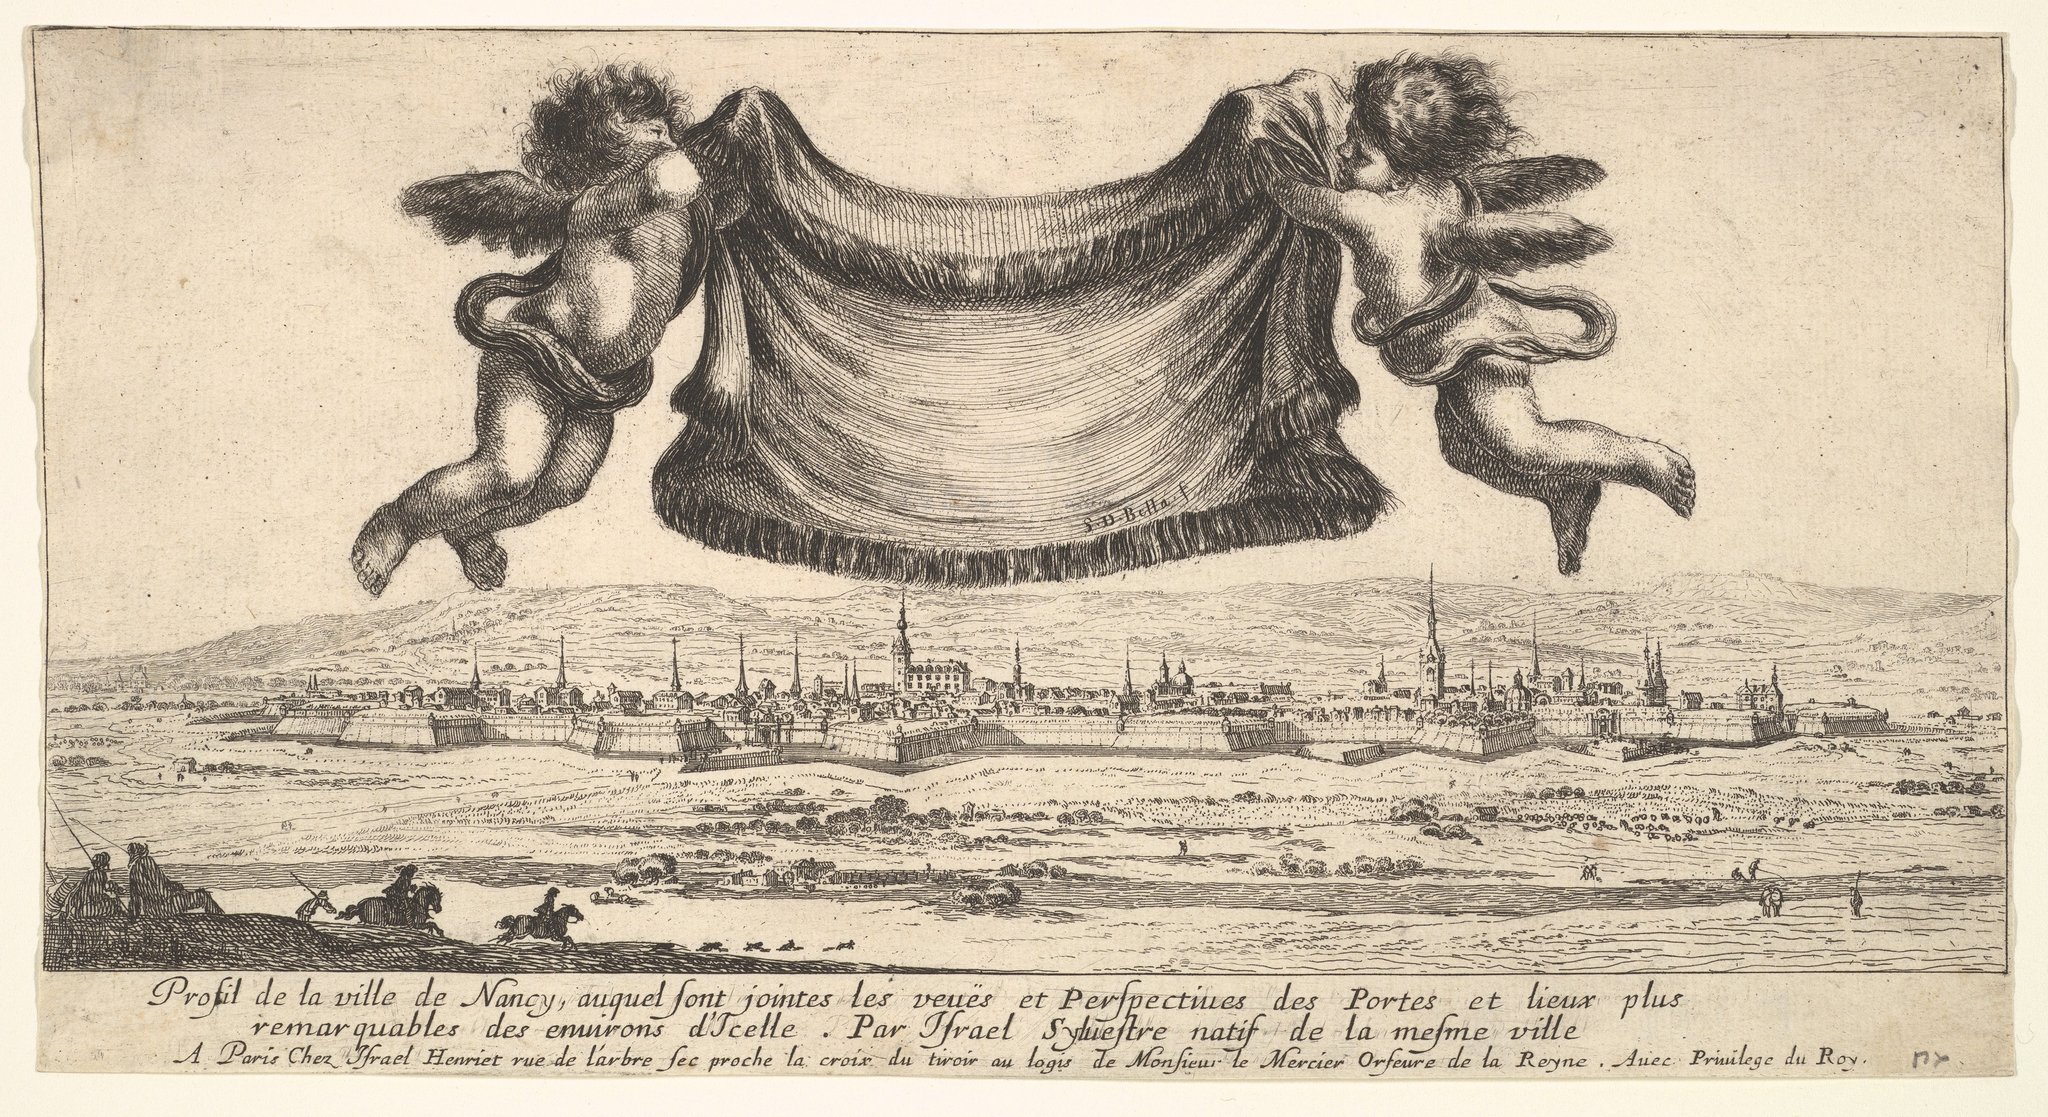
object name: print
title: The villa at Nancy in the background, two putti holding a drapery at top center, from "Various views of remarkable palaces in Italy and France" (Diverses vues d'endroits remarquables d'Italie et de France)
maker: stefano della bella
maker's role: artist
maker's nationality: italian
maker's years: 1610-1664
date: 1649-1651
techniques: etching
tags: towns,putti